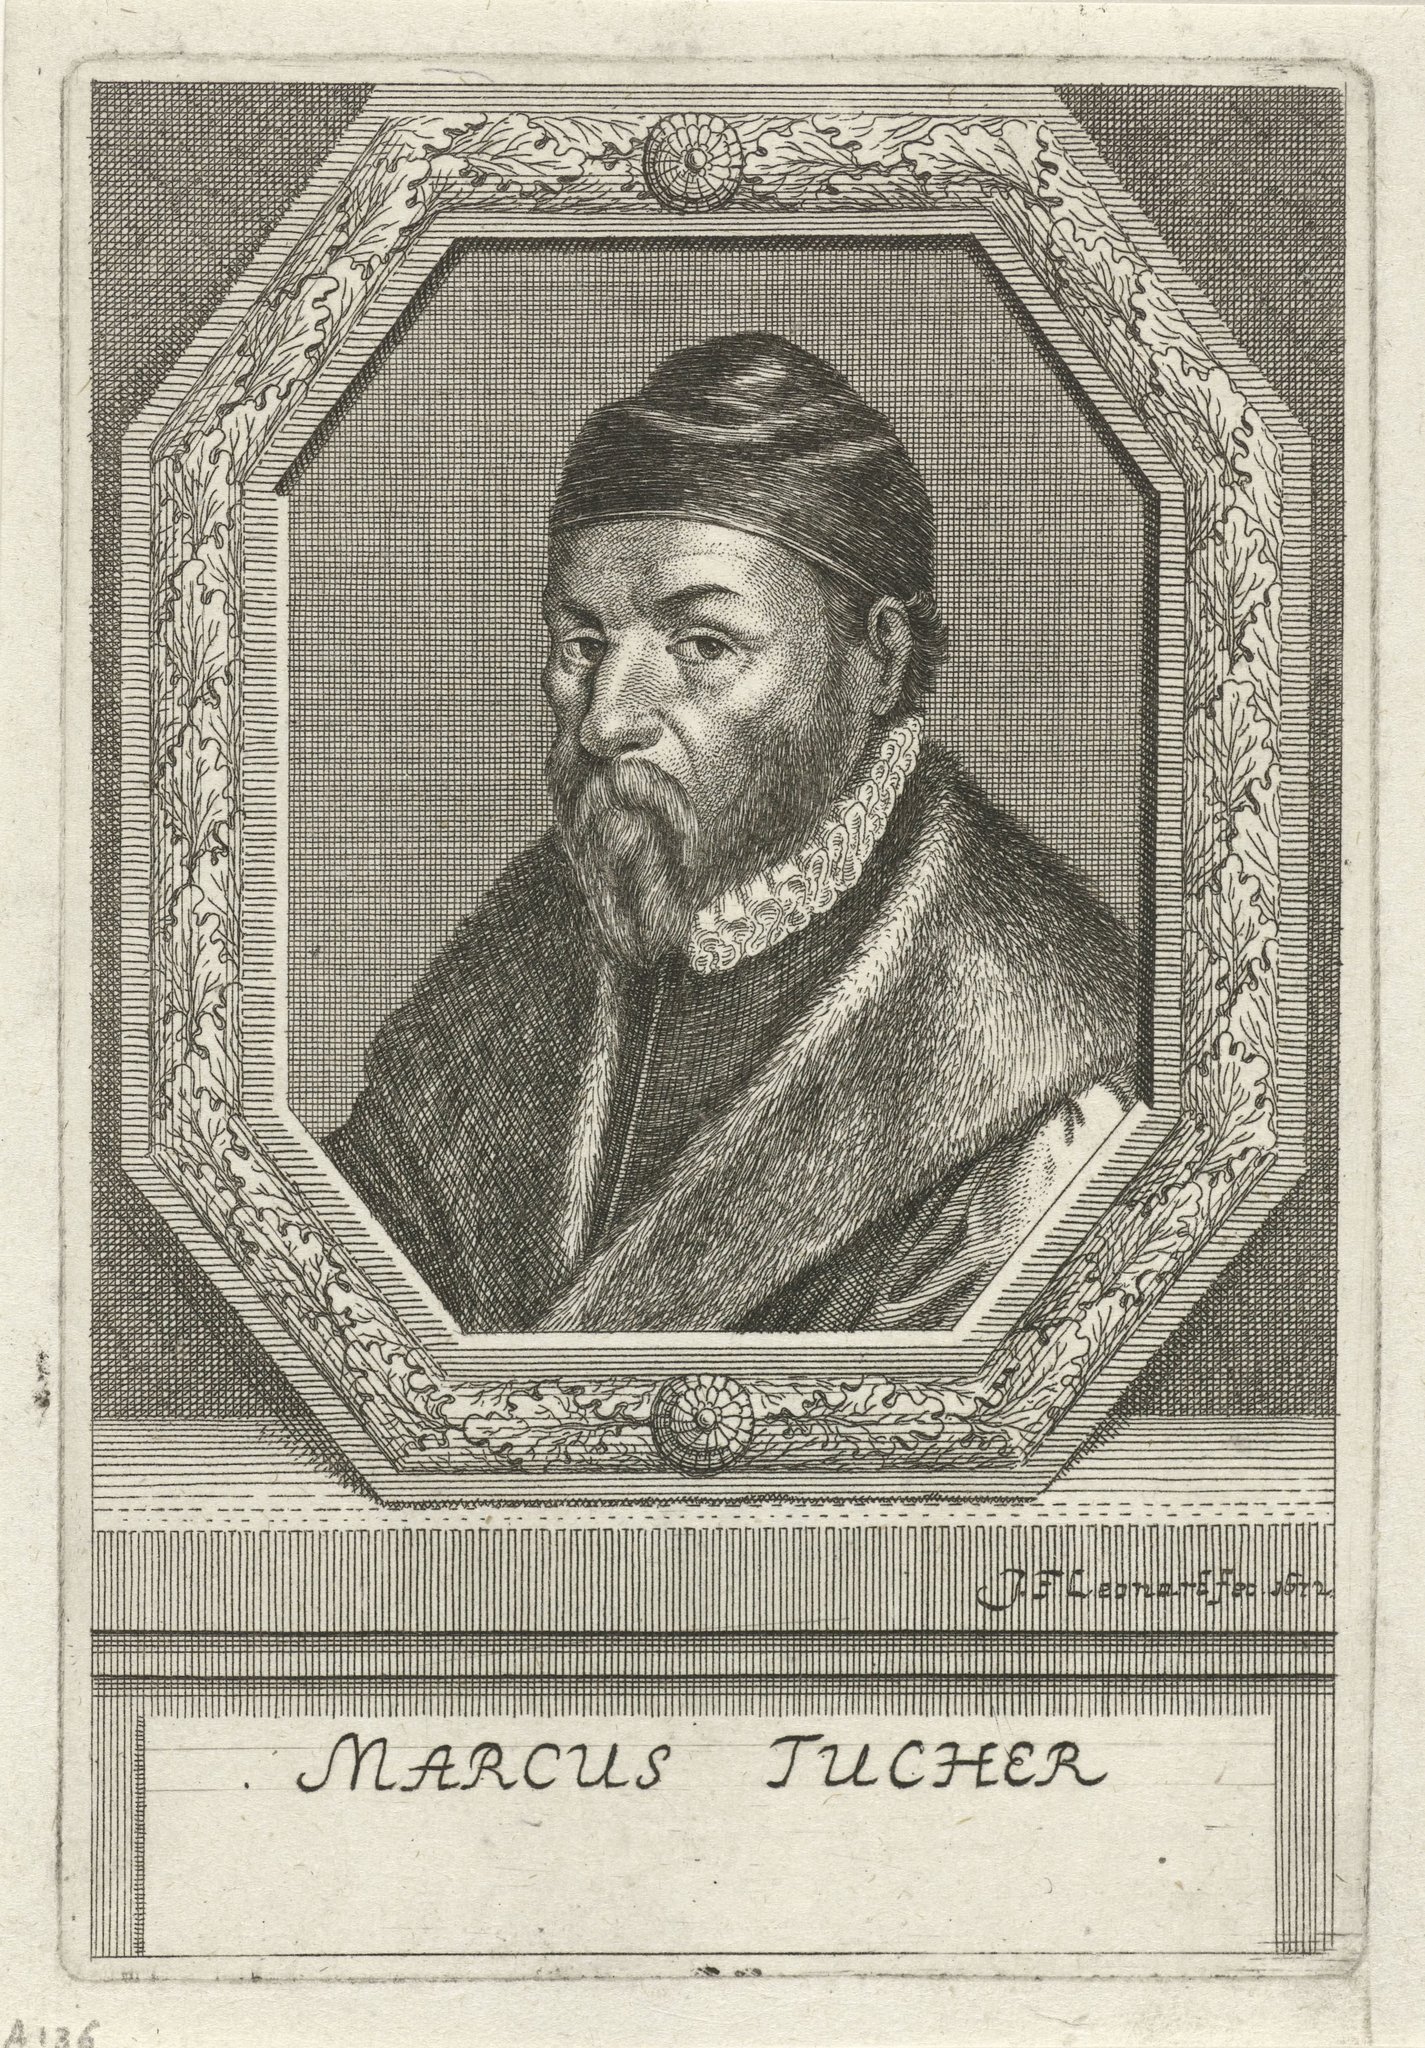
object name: print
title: Portret van Marcus Tucher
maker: johann friedrich leonard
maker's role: print maker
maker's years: 1633-1680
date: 1672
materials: paper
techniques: engraving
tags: senator, marcus tucher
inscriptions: collector's mark: Lugt 2228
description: Portret van Marcus Tucher, senator te Neurenberg.